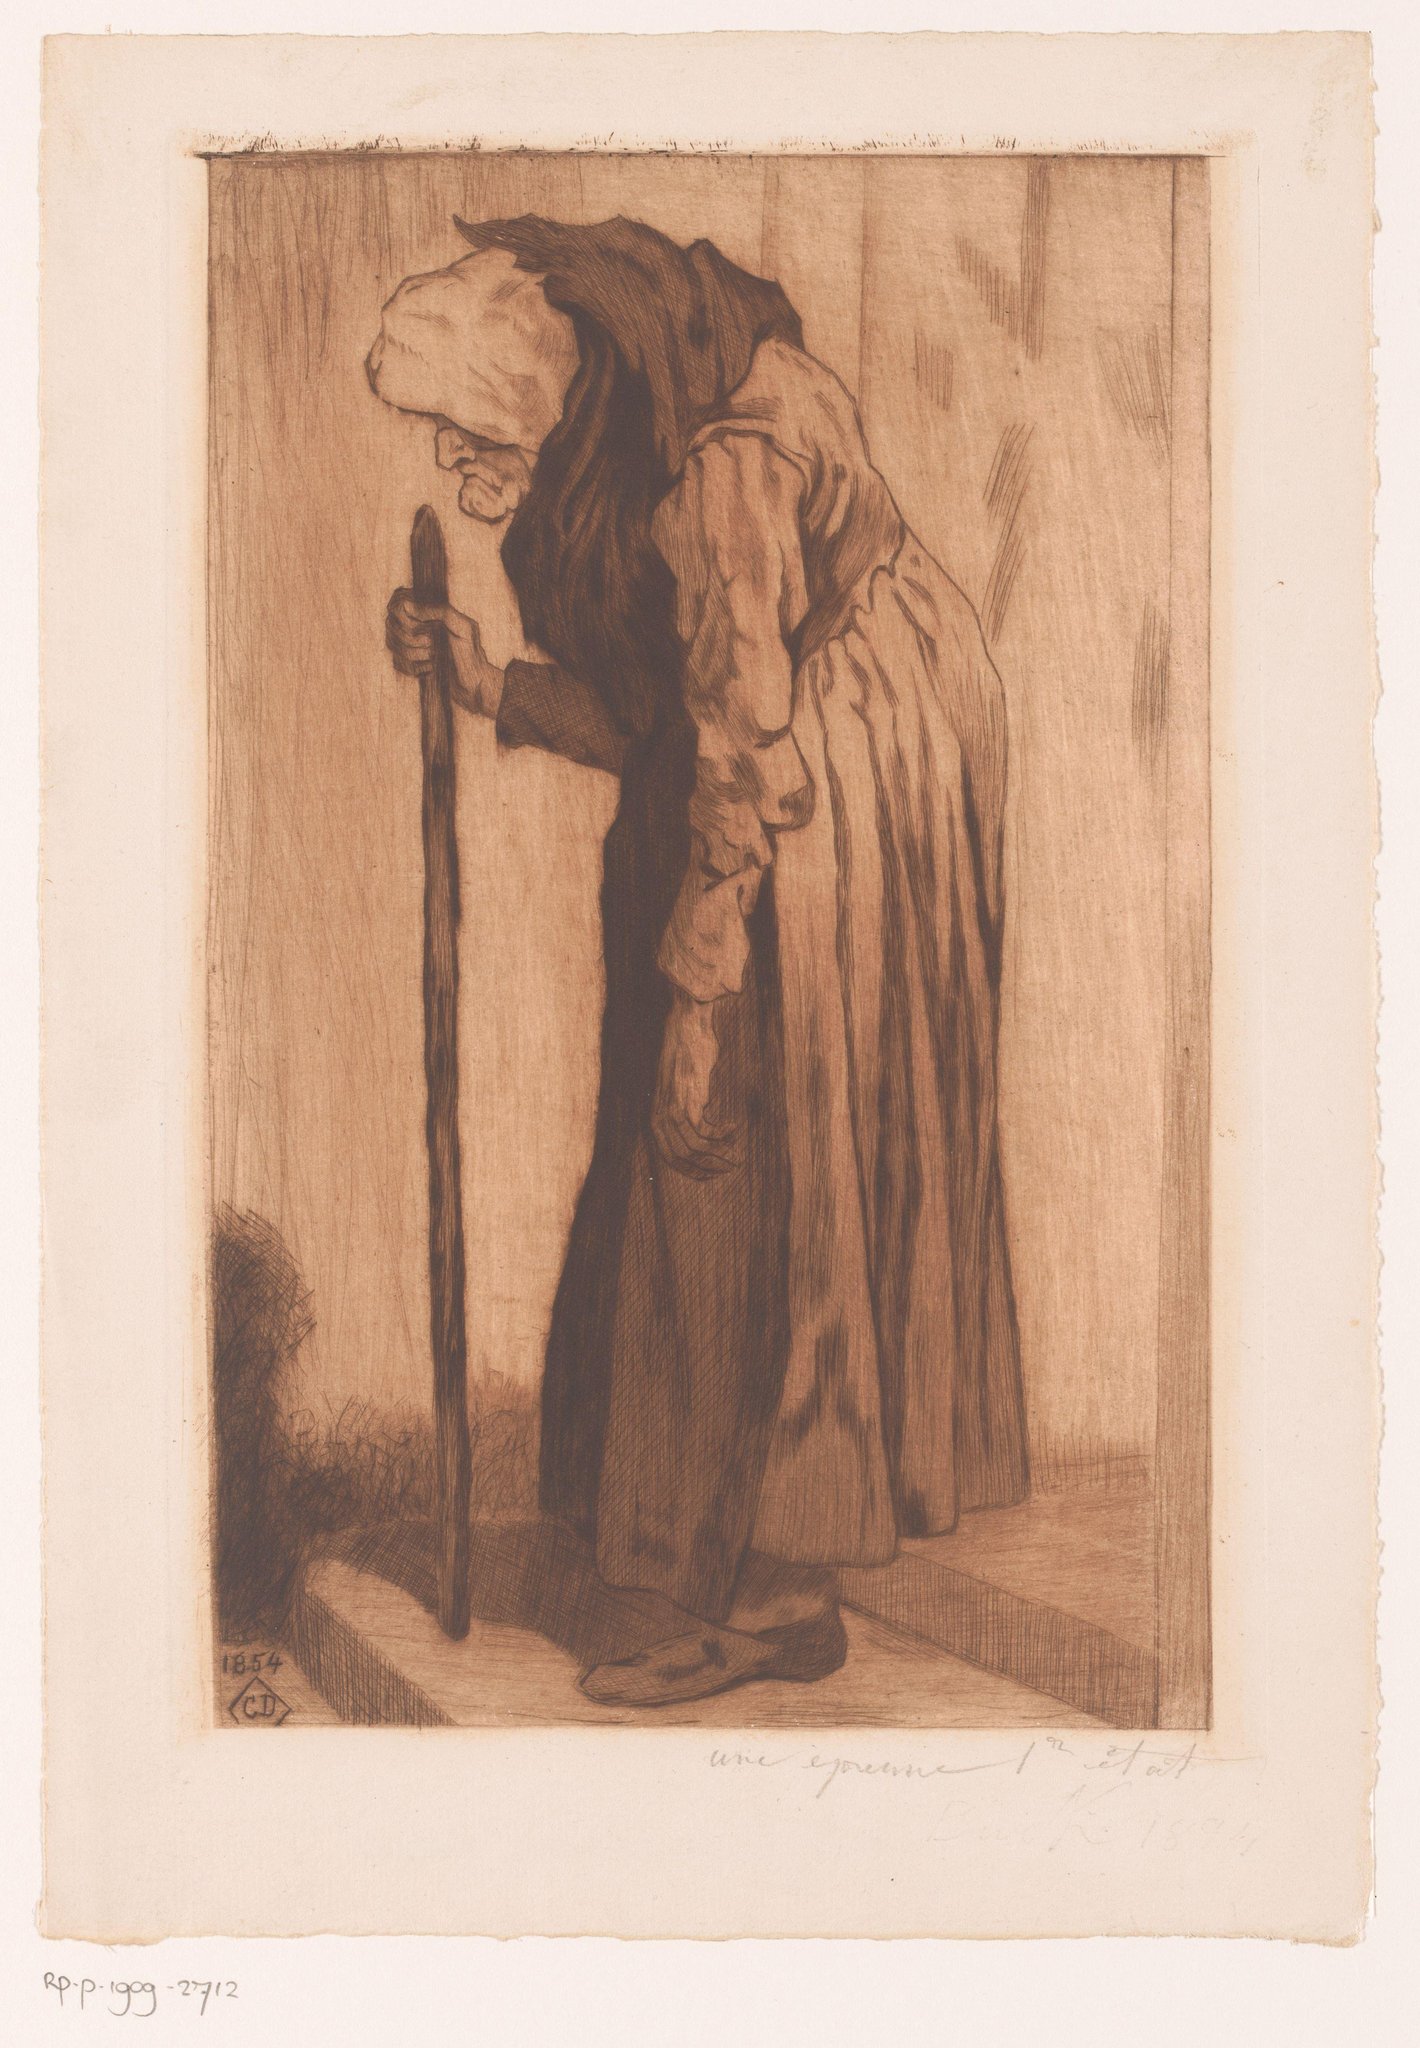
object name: print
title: Op een stok leunende oude vrouw in een deuropening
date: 1885-1909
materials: paper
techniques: drypoint, etching, intaglio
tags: old woman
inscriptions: collector's mark: Lugt 2228, annotation: ‘une epreuve 1er état’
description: Sterfdatum prentmaker onbekend. Derhalve is voor bepaling van de rechten van dit object de verwervingsdatum aangehouden.